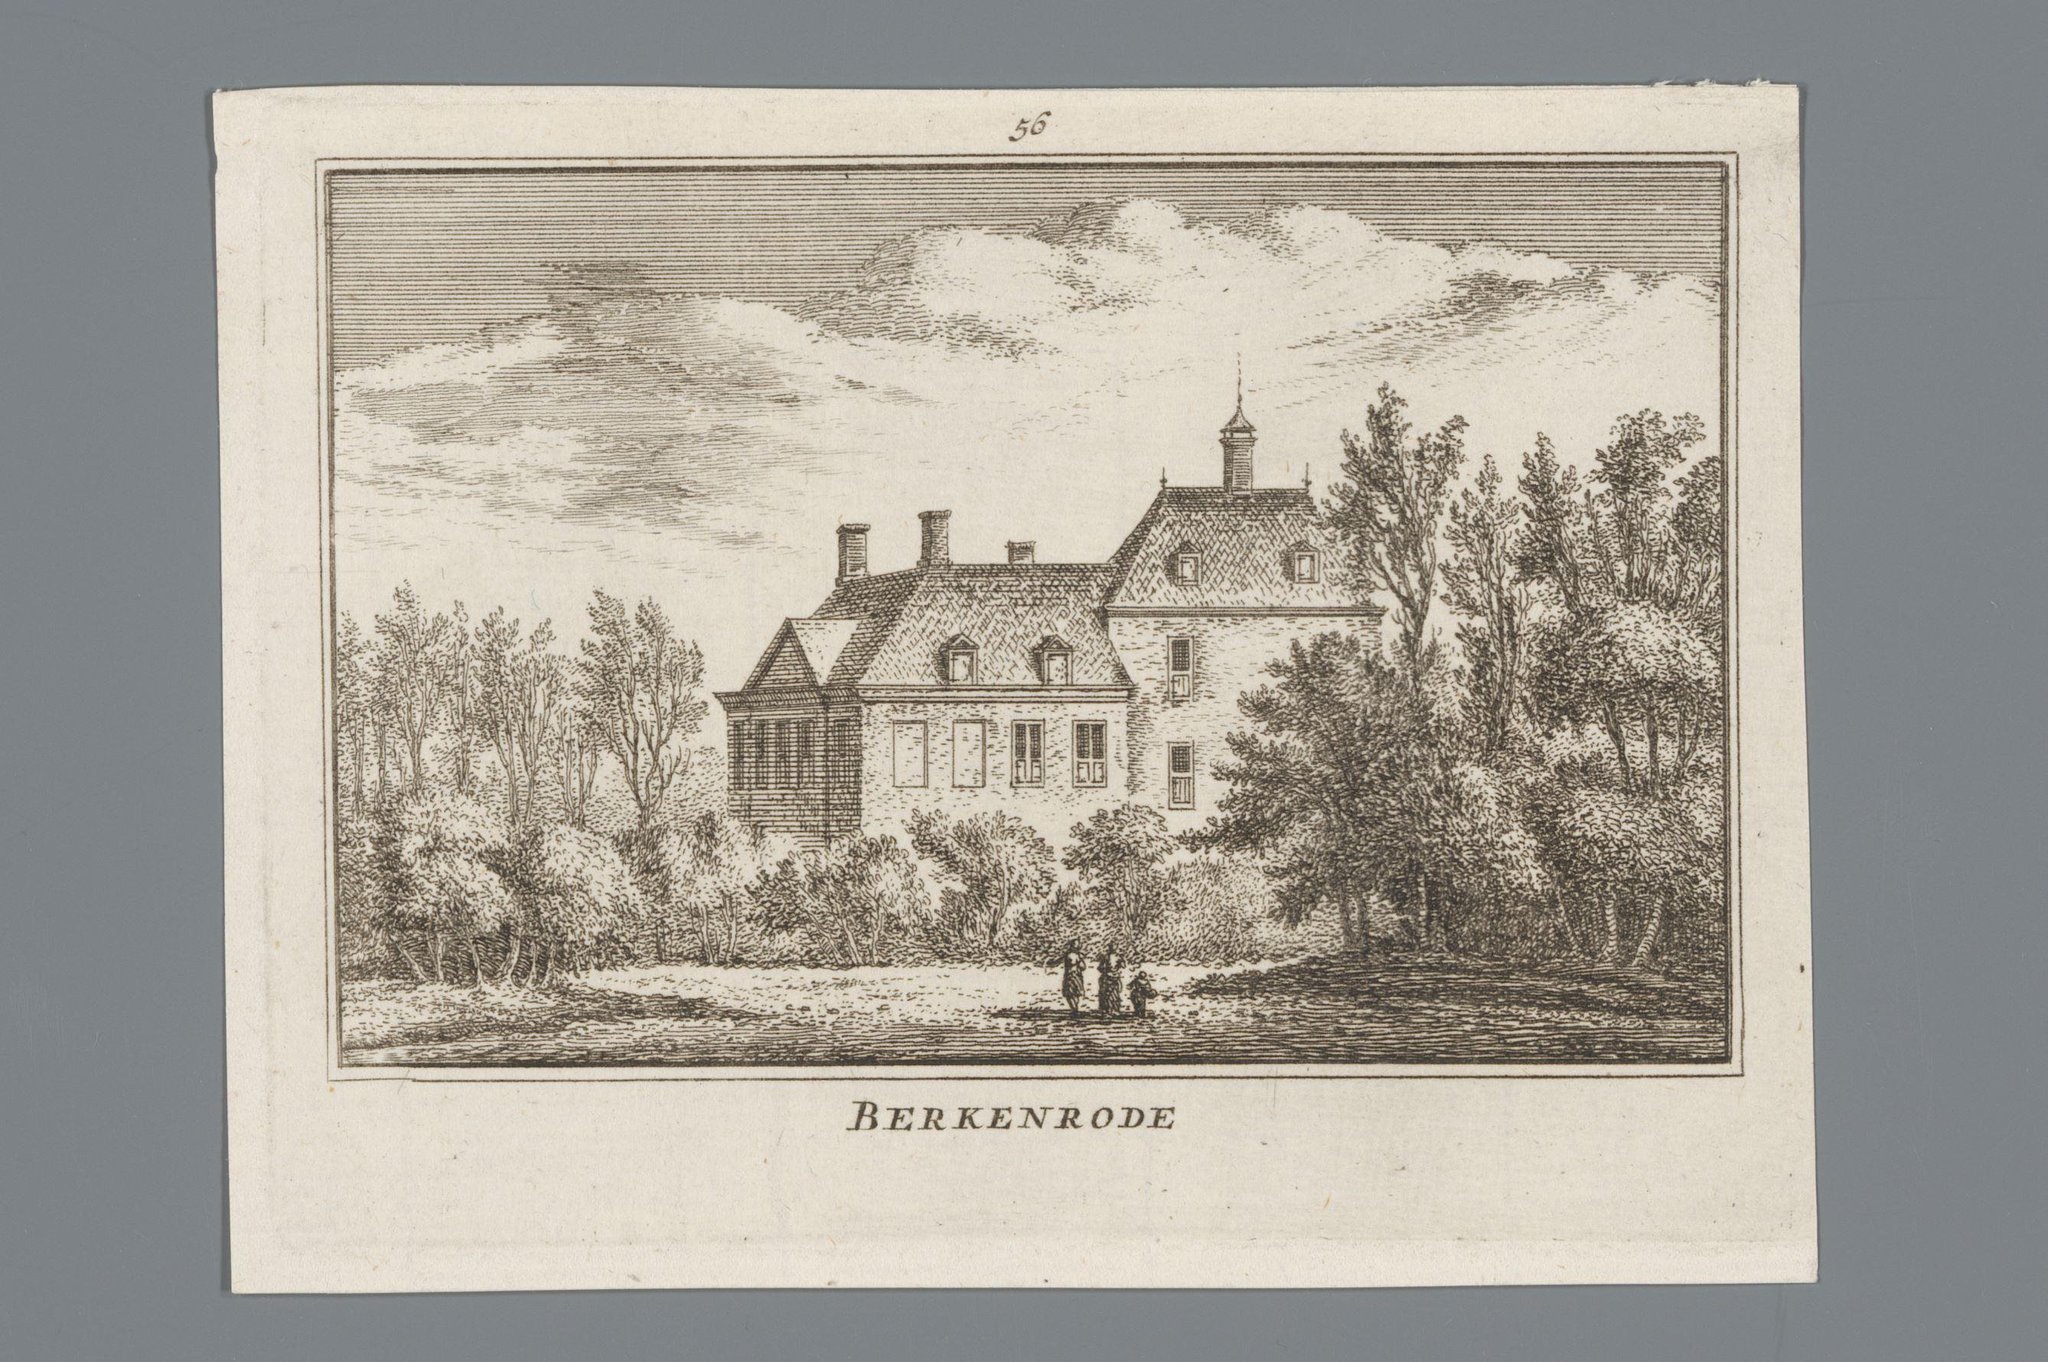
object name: print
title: Gezicht op Oud Berkenrode nabij Haarlem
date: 1725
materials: paper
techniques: etching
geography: amsterdam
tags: villa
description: Prent voor het eerst gebruikt in: Rademaker, Abraham, Matthaeus Brouërius van Niedek, en Isaac Le Long. Kabinet van Nederlandsche en Kleefsche outheden en (...) voorname stads- en landgebouwen. Amsterdam: Willem Barents, 1725, ill. nr. 56. Daarna in heruitgaven verschenen, uitgegeven in 1727-1733, 1770-1771 en 1792-1803.